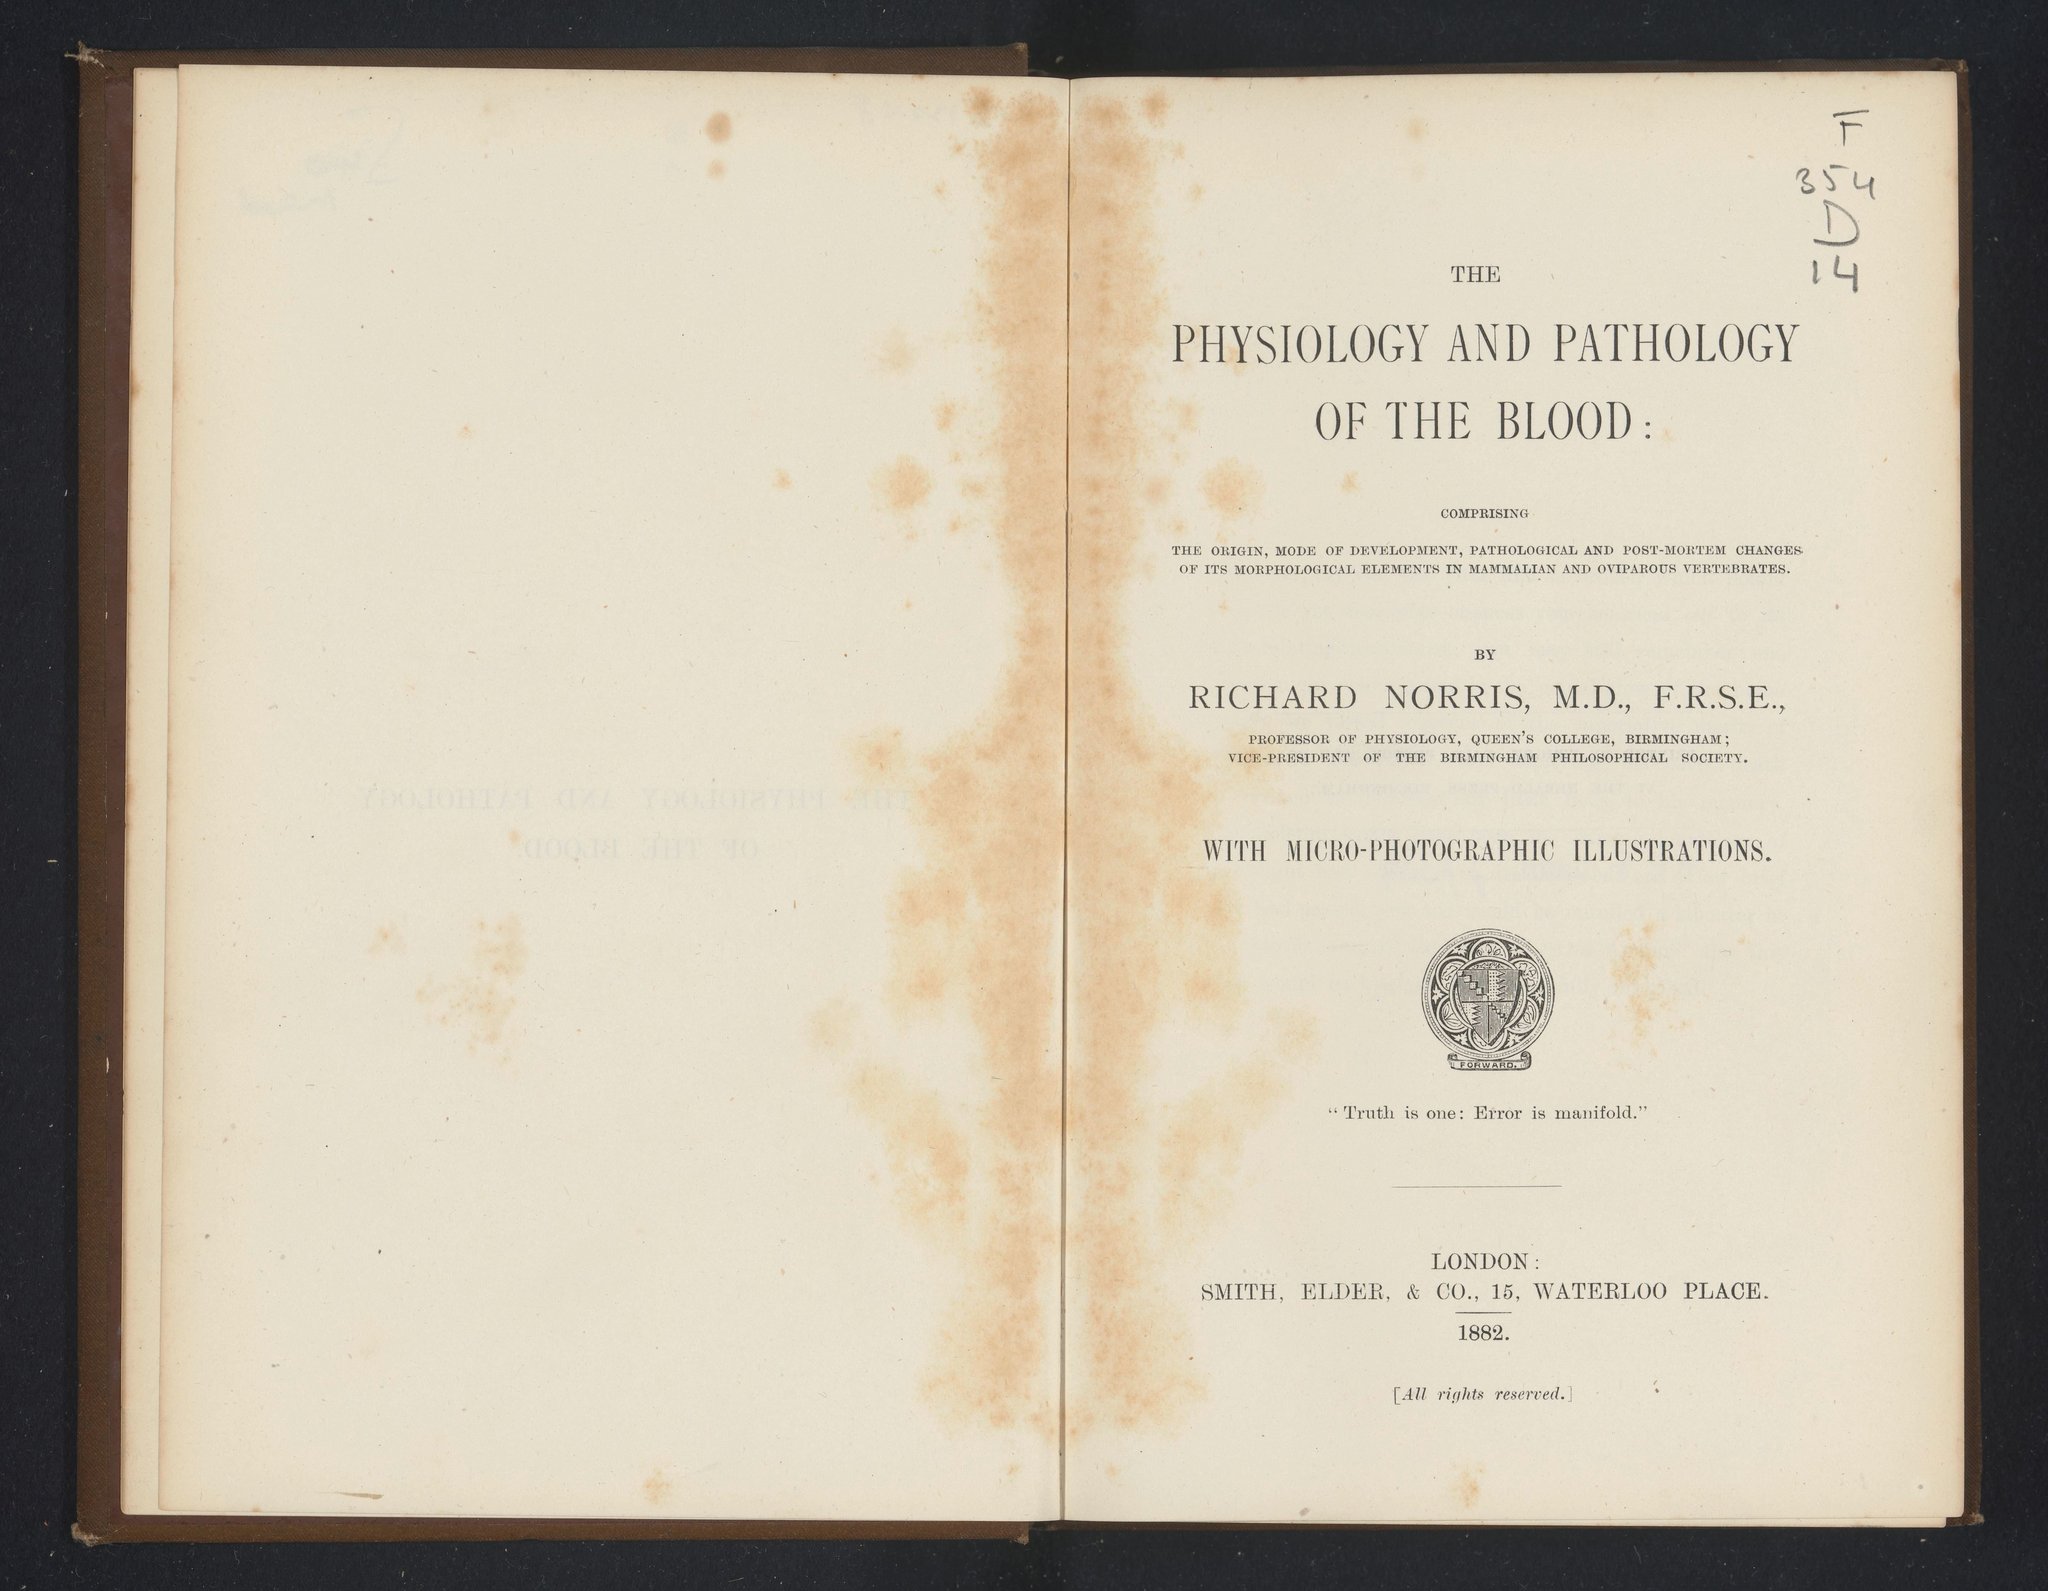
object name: book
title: The physiology and pathology of the blood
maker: richard norris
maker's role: fotograaf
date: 1882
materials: cardboard, linen, paper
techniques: photograph, printing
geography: london